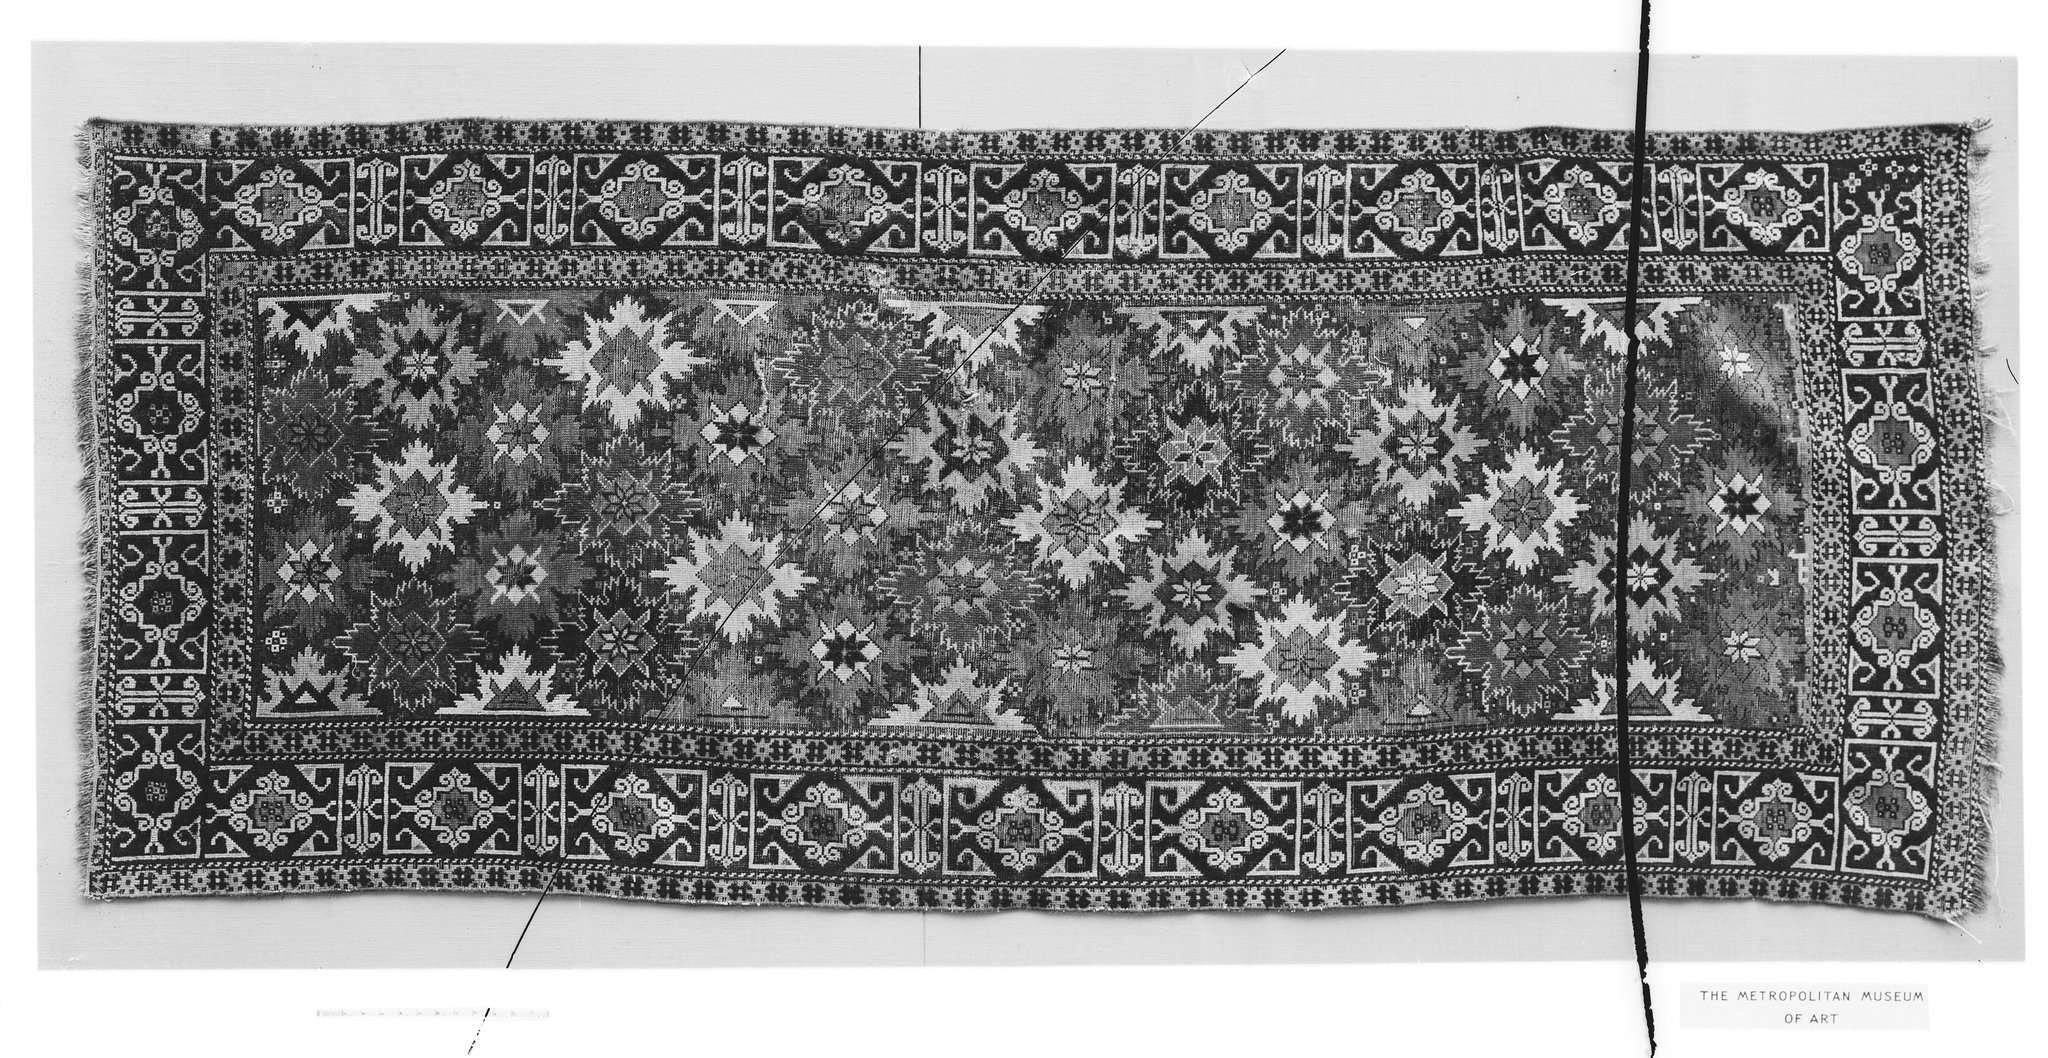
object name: carpet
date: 1801-1900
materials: wool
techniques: pile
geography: azerbaijan